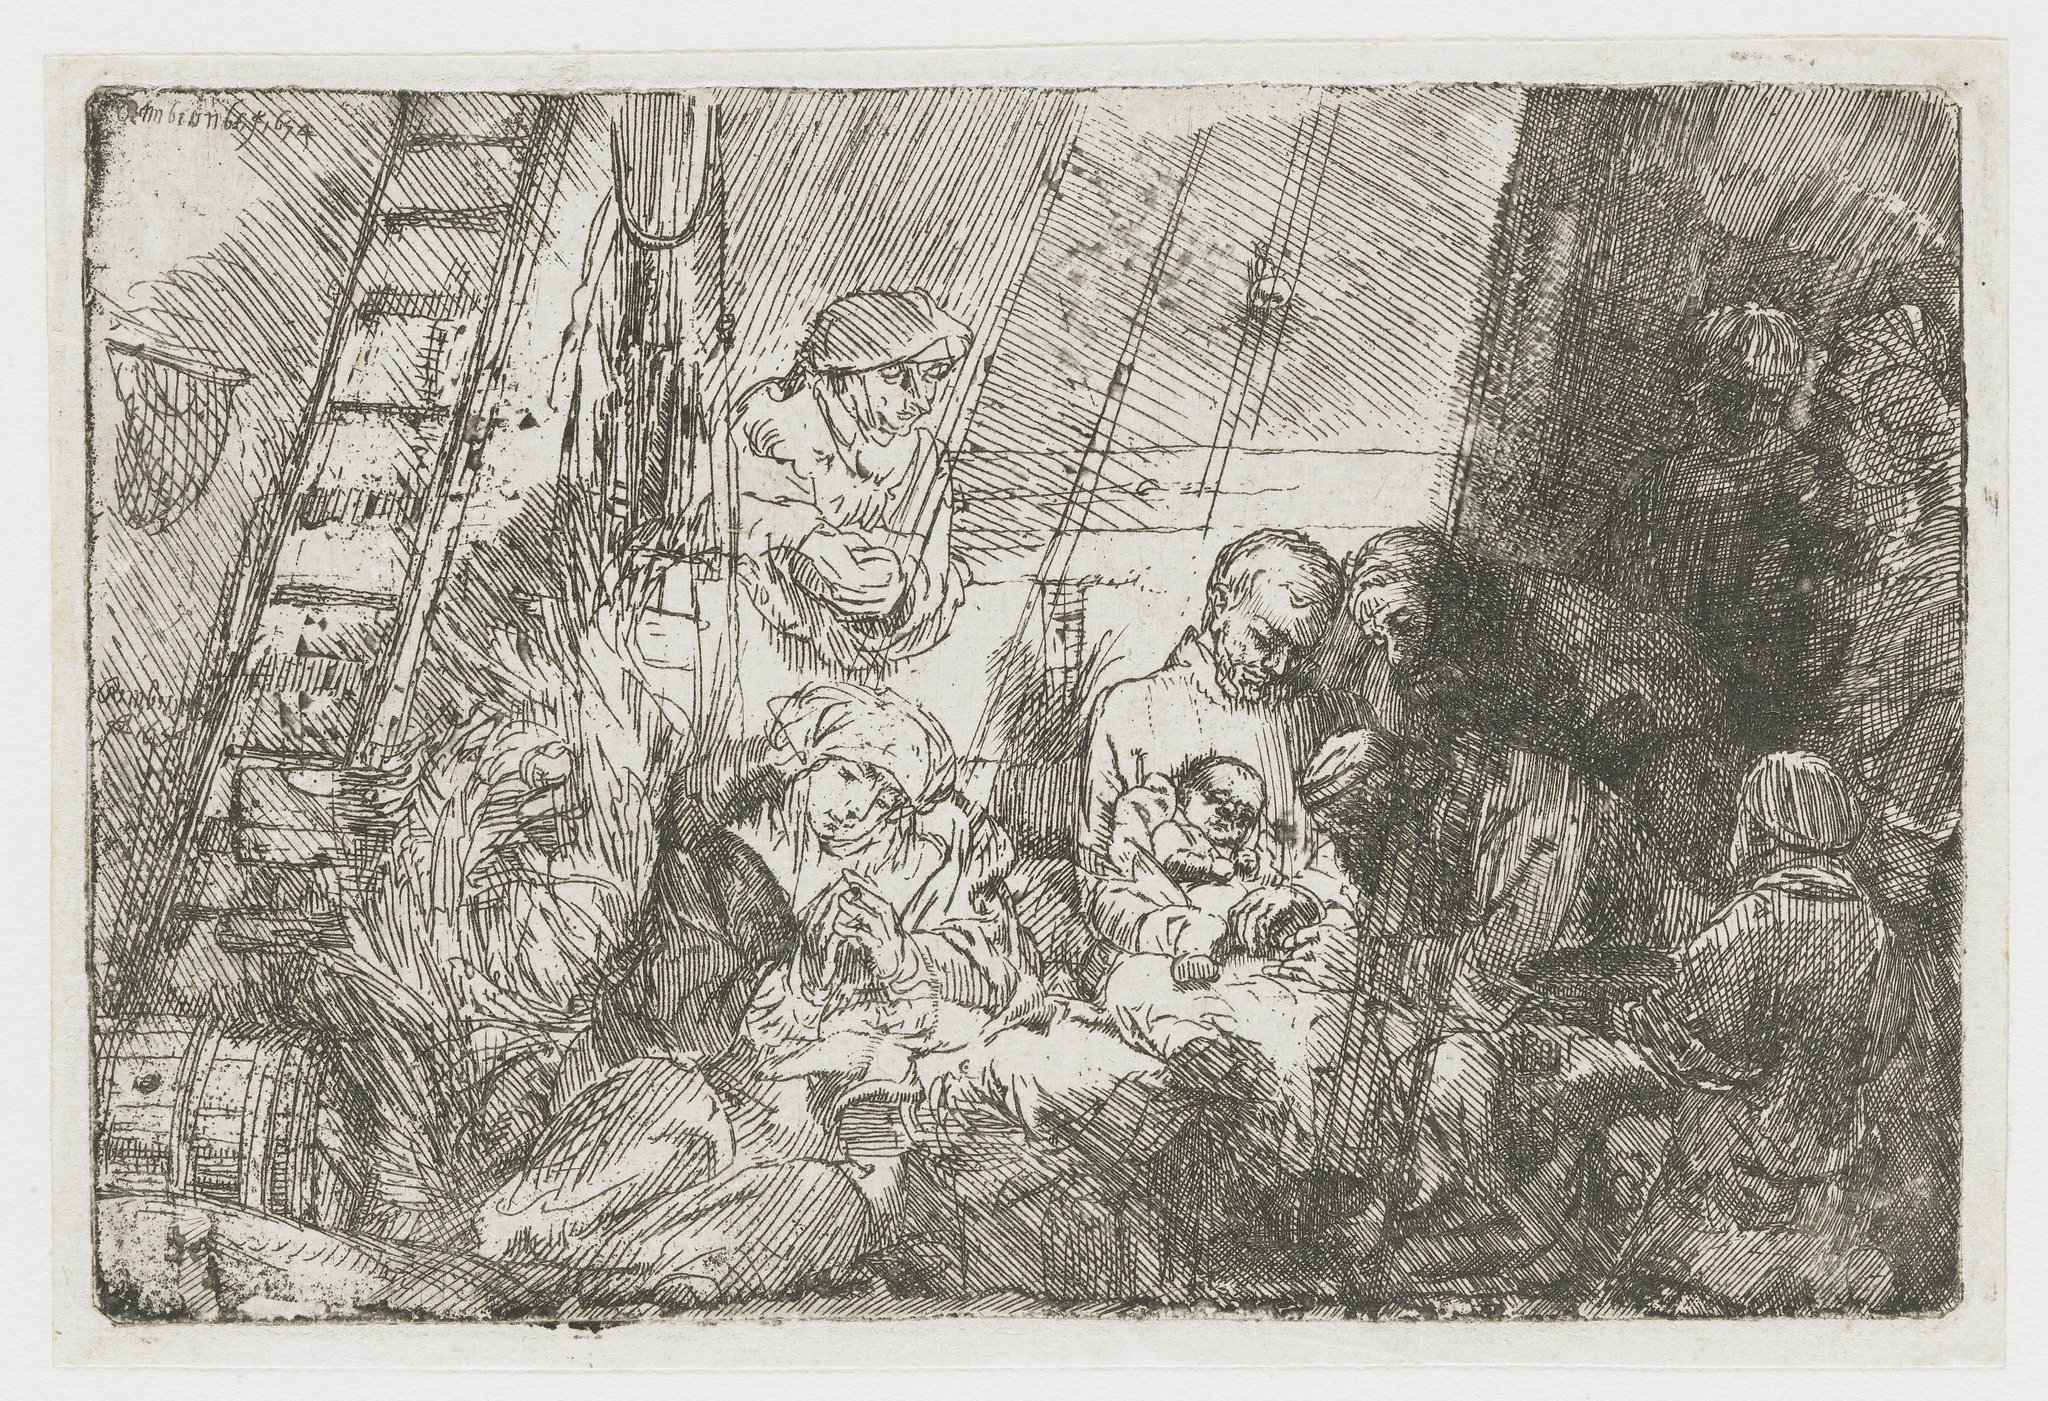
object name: print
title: The circumcision in the stable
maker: rembrandt van rijn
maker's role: draughtsman, painter, print maker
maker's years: 1606-1669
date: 1654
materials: paper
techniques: etching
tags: circumcision of the christ-child by mary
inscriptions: signature and date: ‘Rembrandt f. 1654’, collector's mark: Lugt 240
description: All of Rembrandt’s etchings are pulled from a copperplate. To make an etching, he would cover the plate with a mixture of resin and beeswax, then draw through that surface with a needle to expose the metal. The plate was immersed in acid, which ‘bites’ grooves in these exposed areas. When the plate was inked and put through a printing press with a sheet of paper, an impression of the design appears on the paper.